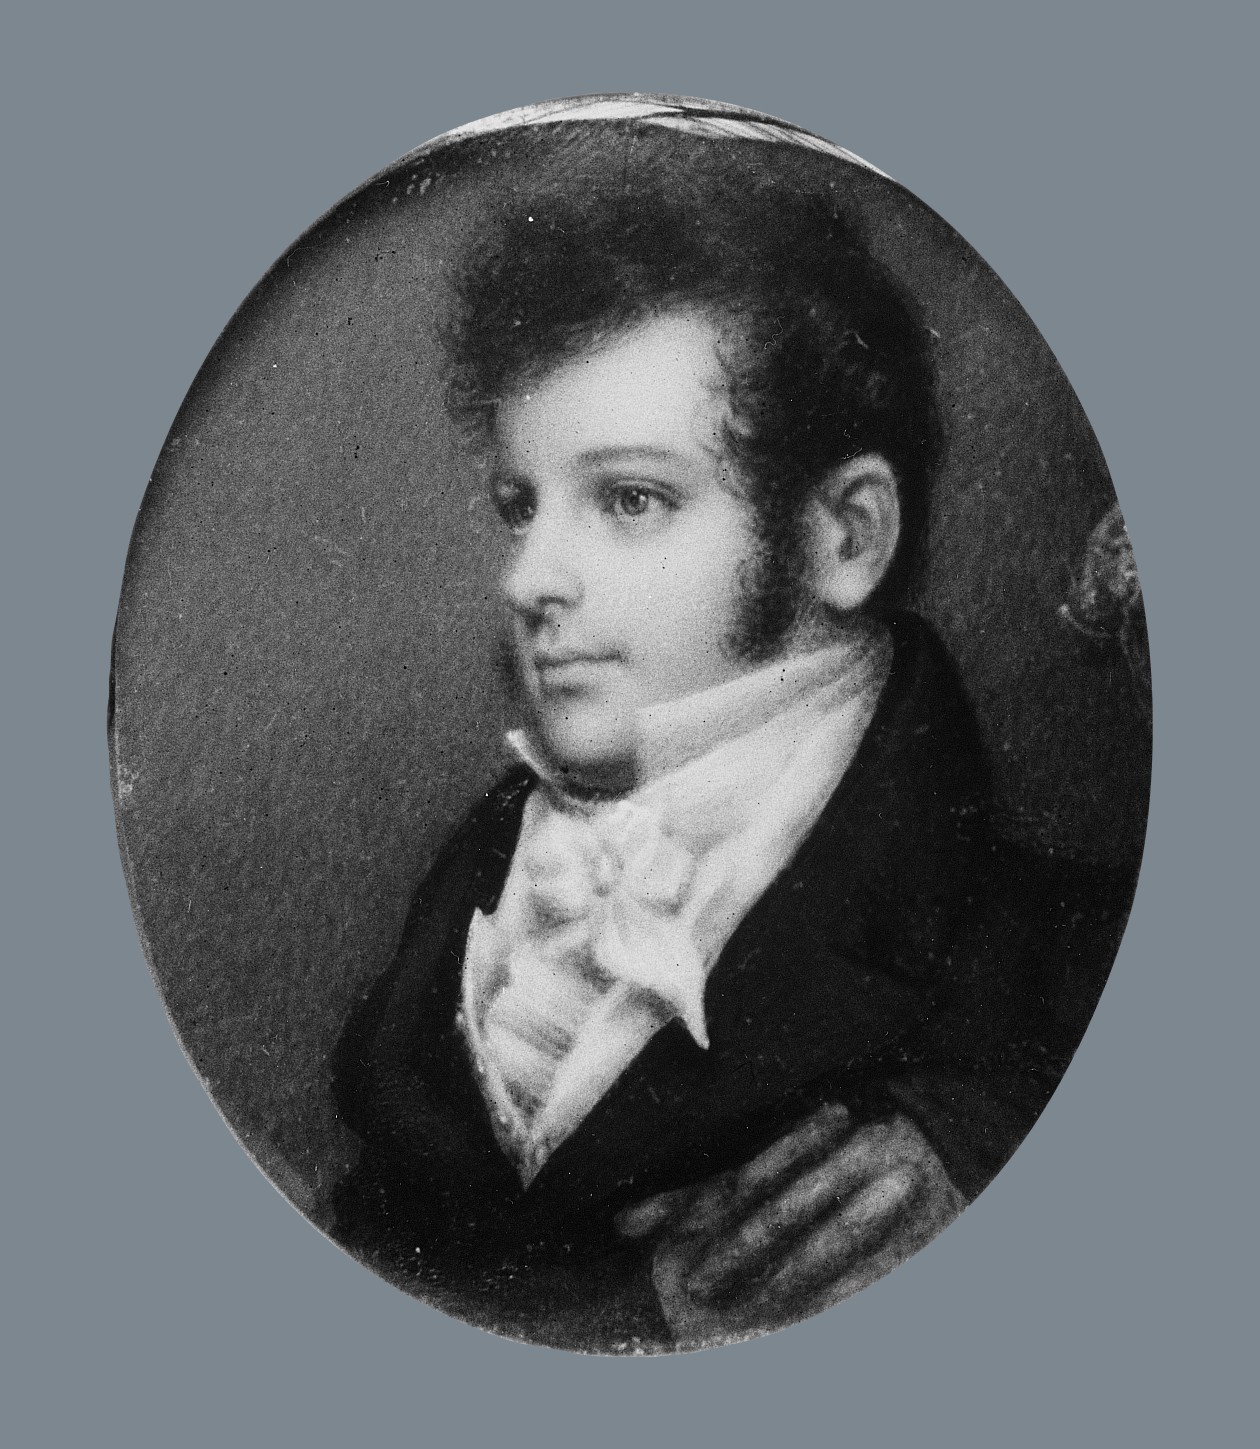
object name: painting, miniature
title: Portrait of a Gentleman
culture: american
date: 1810-1815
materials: ivory, watercolor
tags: men,portraits